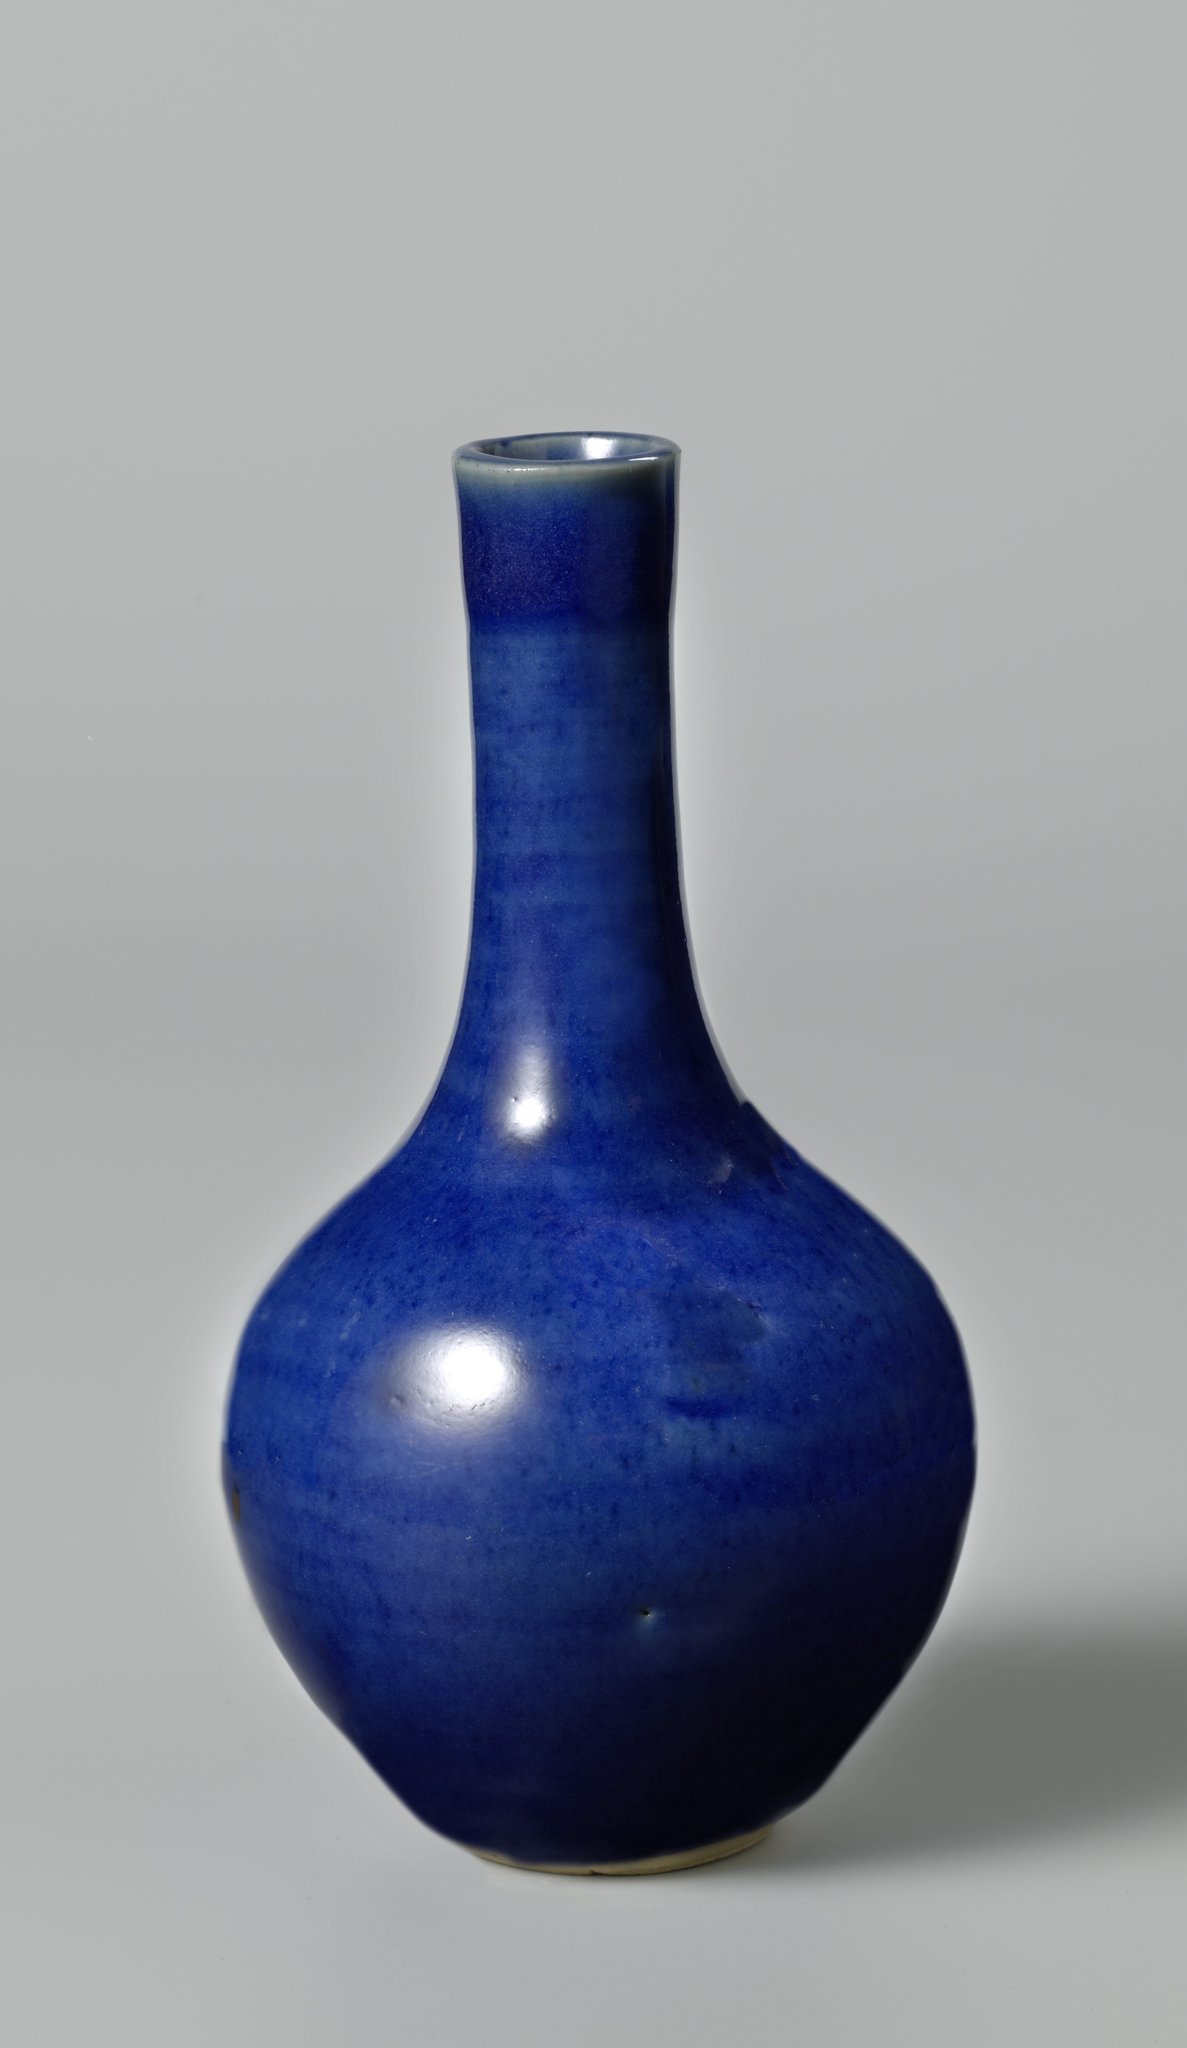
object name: vase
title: Bottle vase with powder blue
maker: Anonymous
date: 1800-1899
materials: cobalt, glaze, paint, porcelain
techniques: firing, turning, vitrification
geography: china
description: Vase and Bowl. This type of underglaze blue is called ‘powder blue’. It was achieved by spraying the cobalt pigment through a tube covered at the end with gauze on the unfired piece. The pigment particles were thus unevenly distributed over the surface. The object was then fired and glazed. The result is a lively blue structure with an effect of depth.